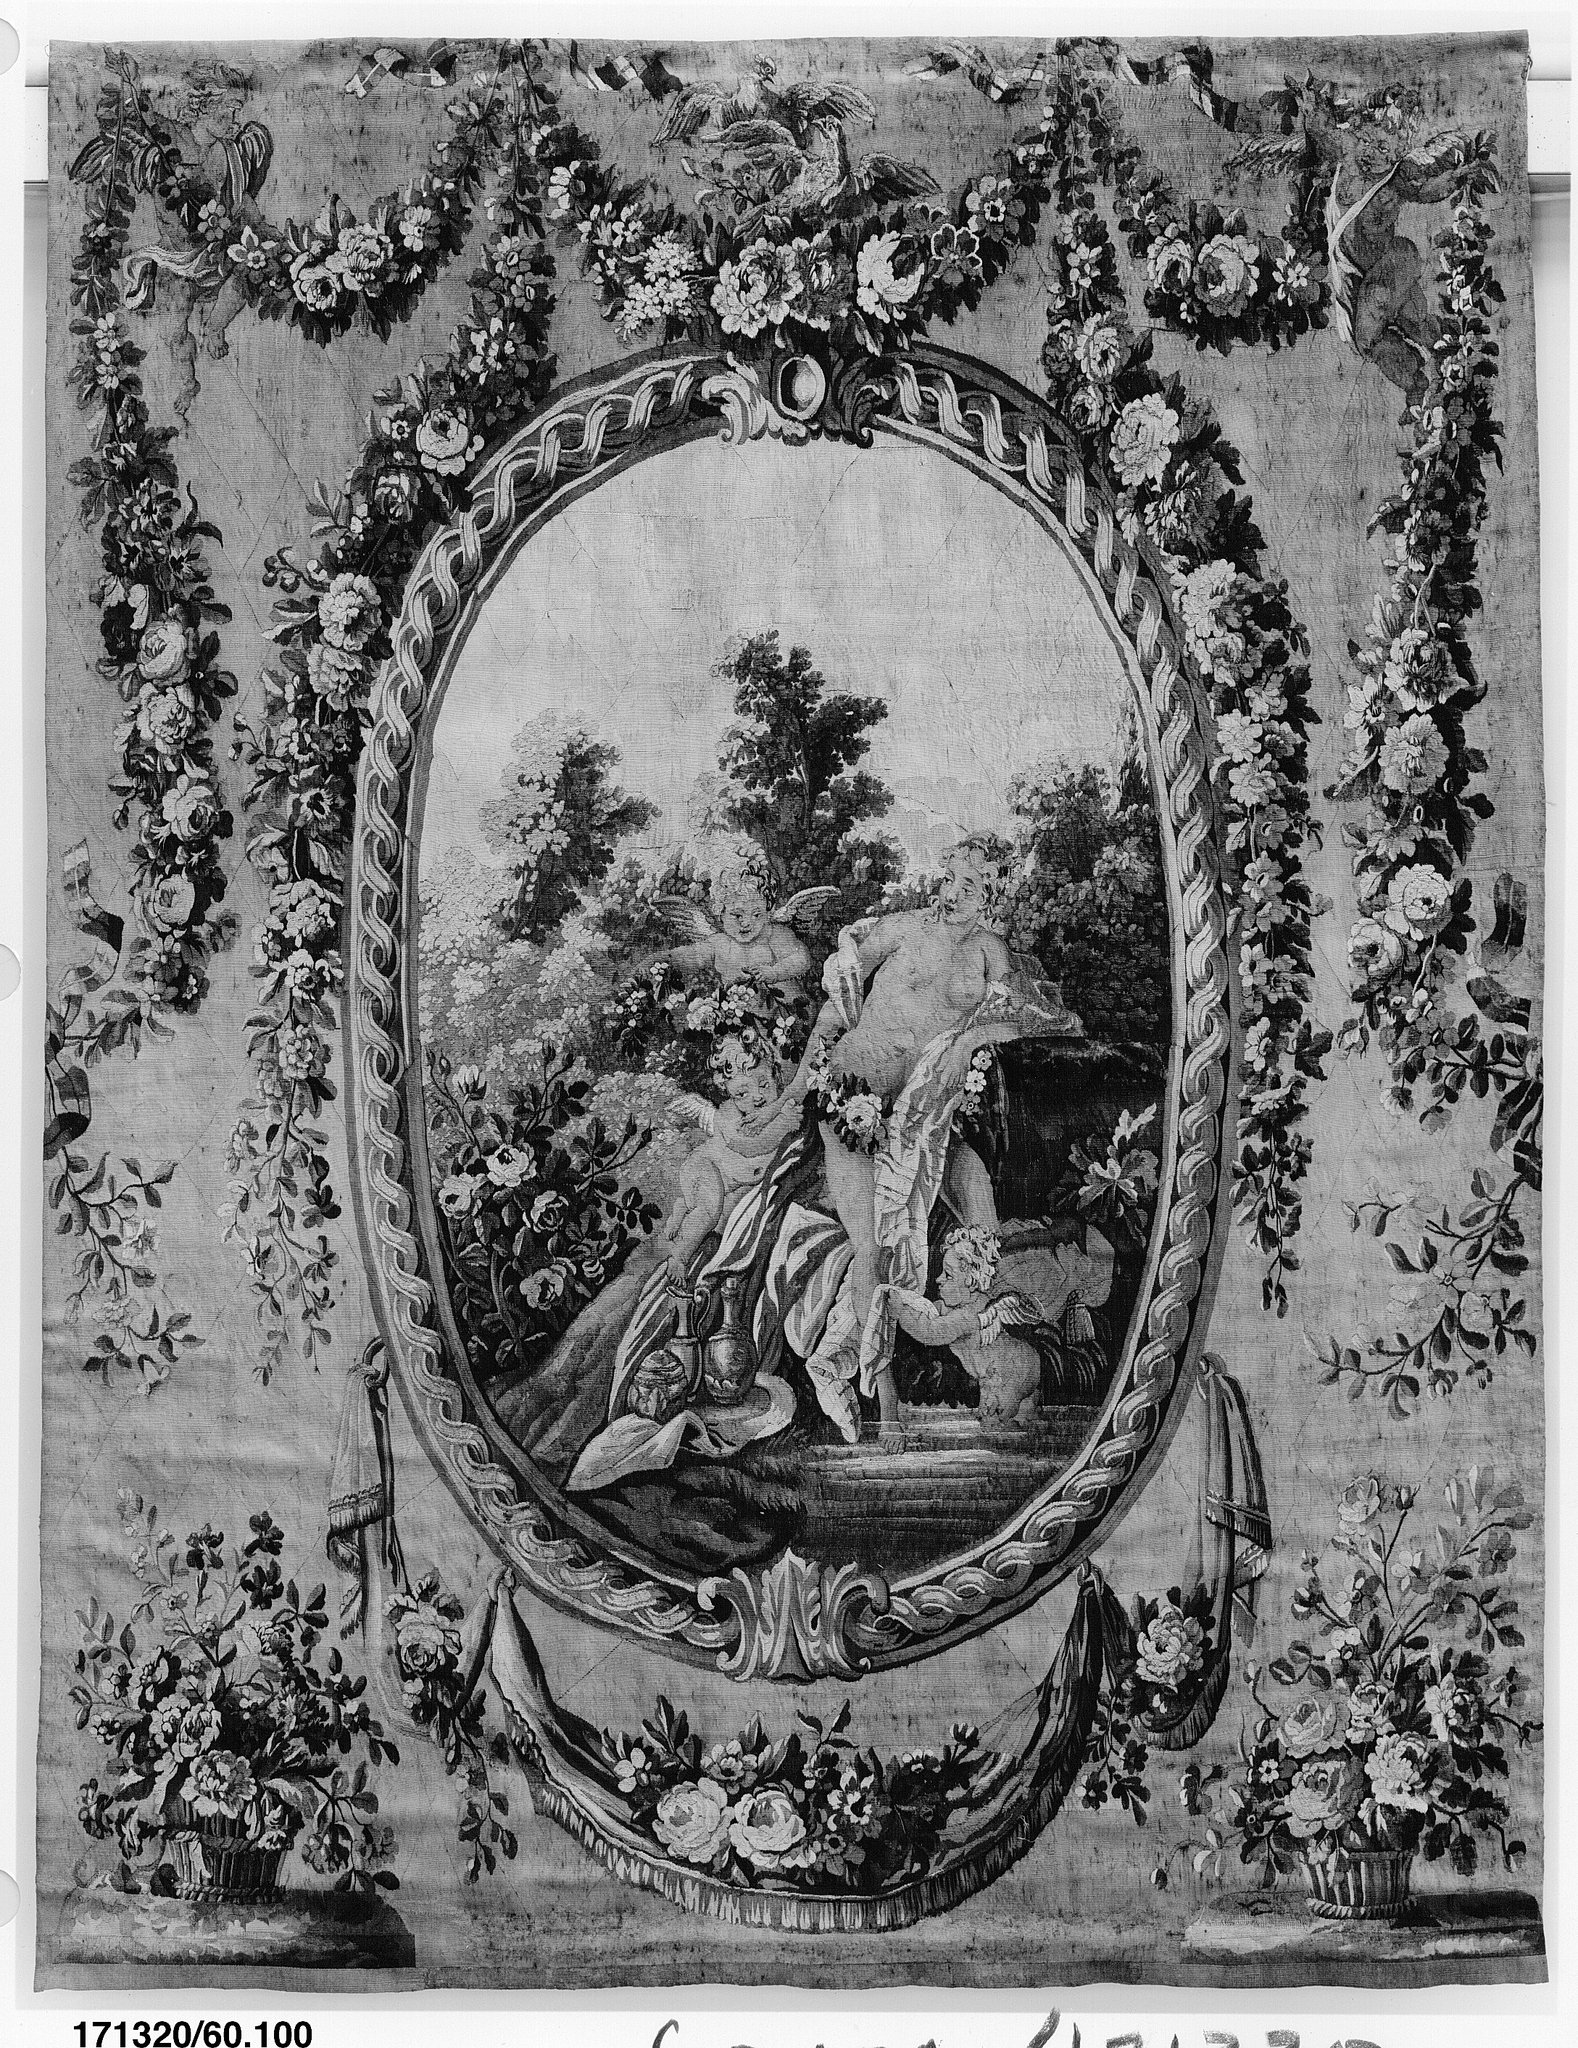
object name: tapestry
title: The Toilet of Venus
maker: aubusson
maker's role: manufactory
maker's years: 1665-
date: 1770-1780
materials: silk, wool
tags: garlands,cupid,venus,flowers